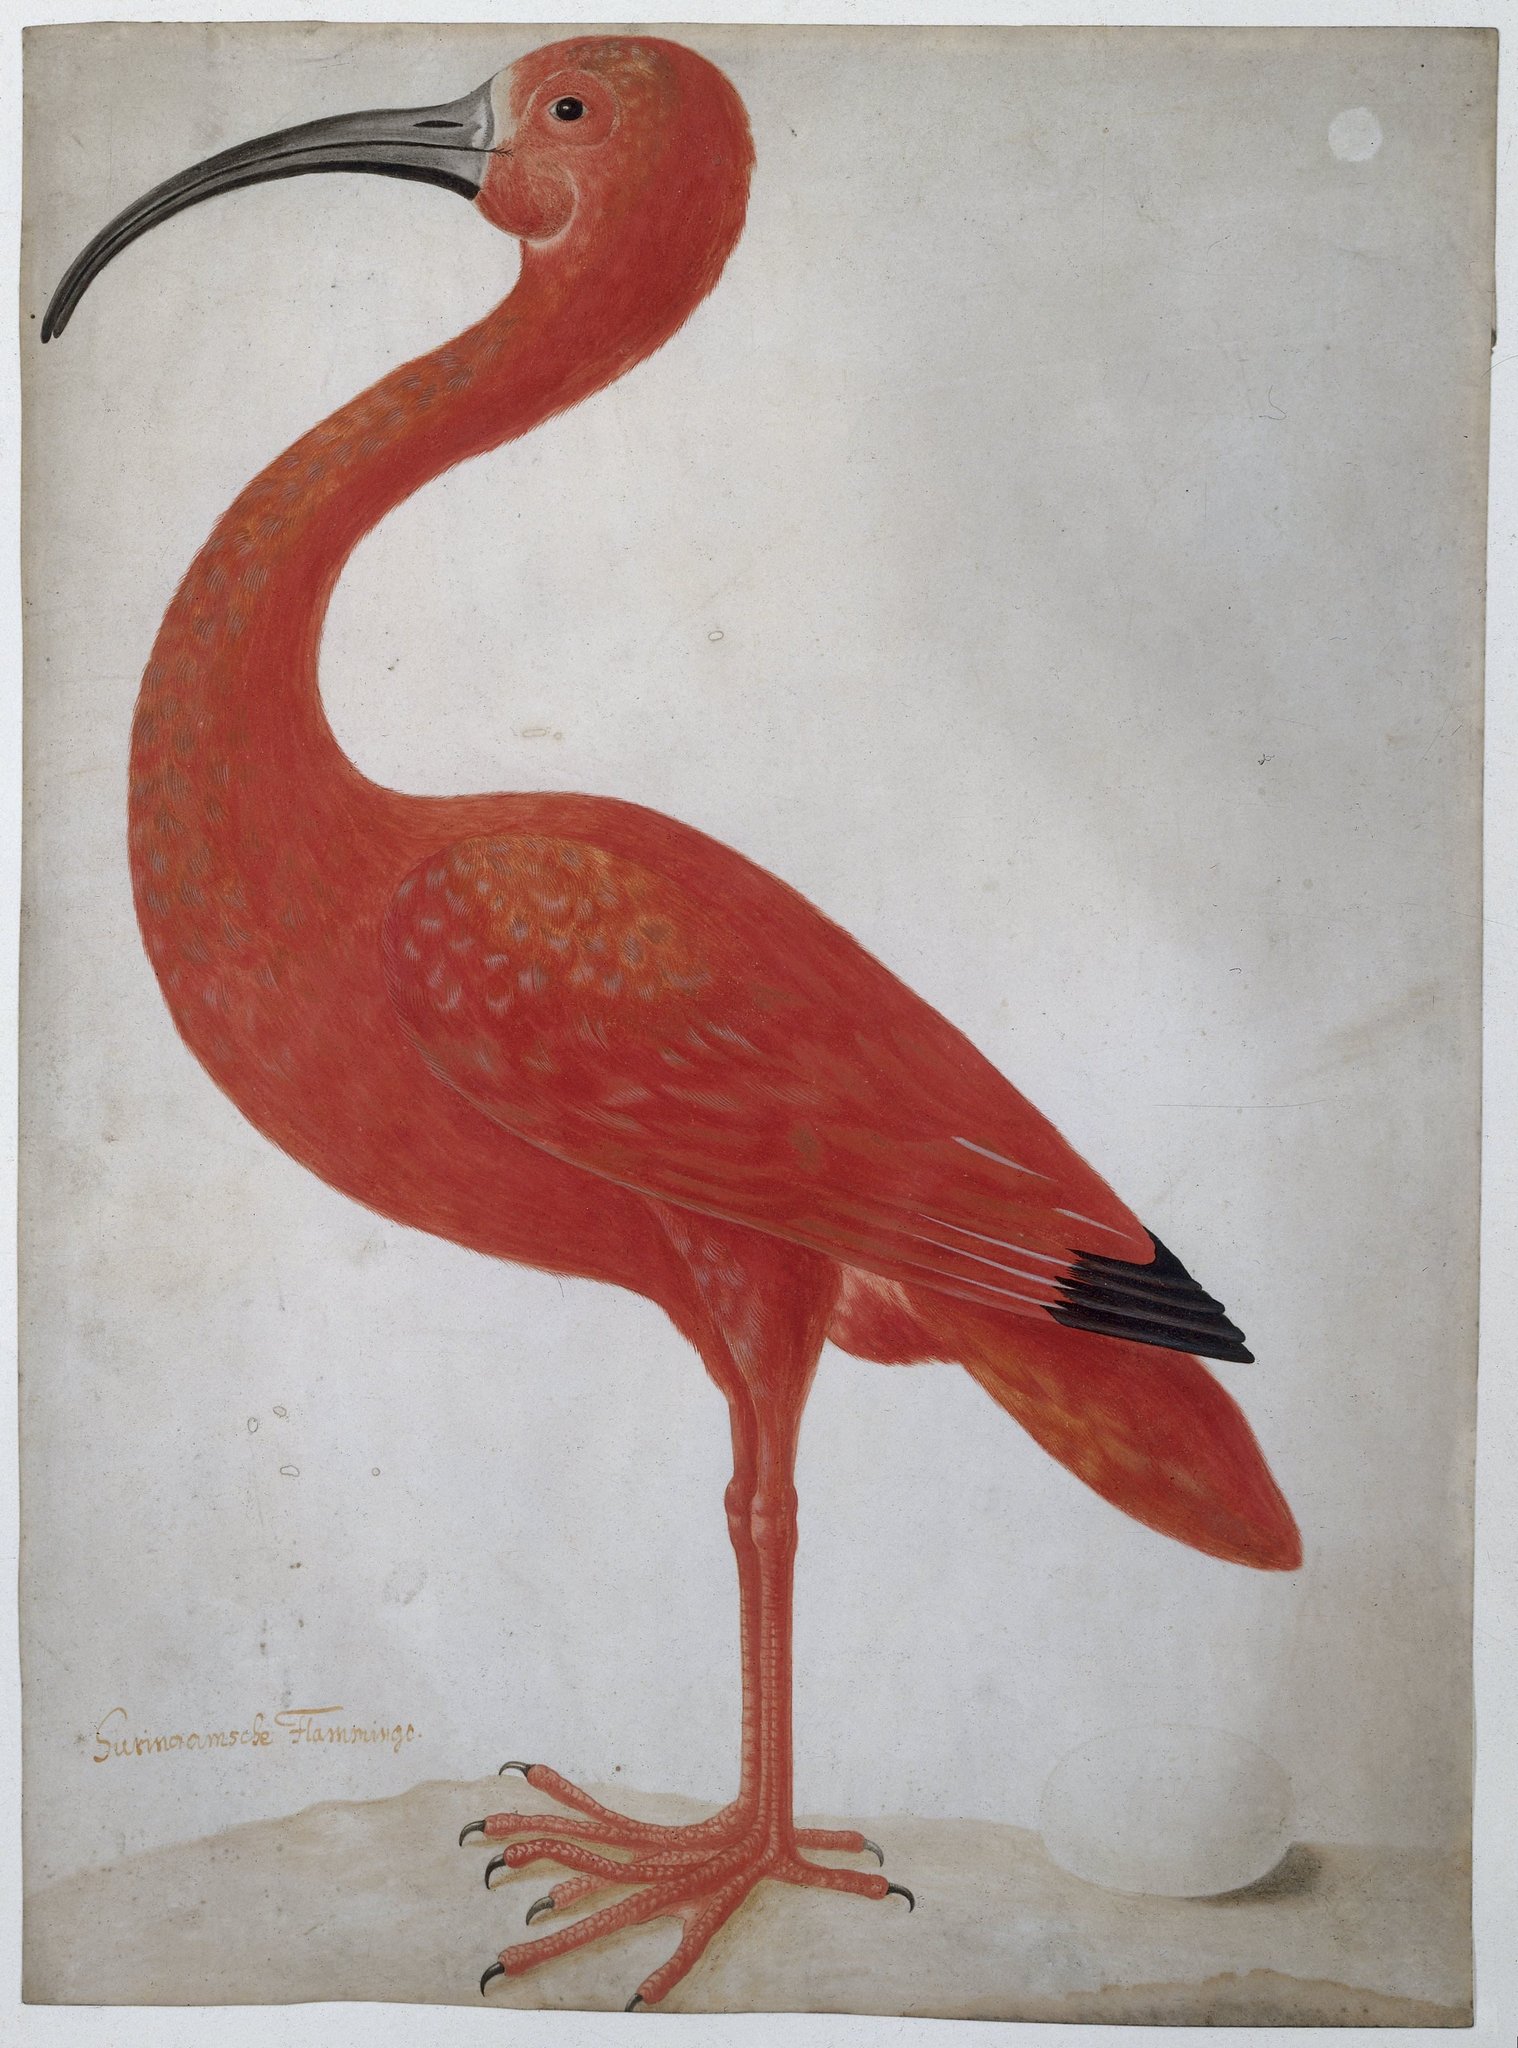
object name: drawing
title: Scarlet Ibis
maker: dorothea maria gsell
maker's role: draughtsman, painter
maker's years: 1678-1743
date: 1699-1701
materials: paint, gouache, parchment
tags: shore-birds and wading-birds: red ibis, shore-birds and wading-birds: red ibis (egg)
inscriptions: : ‘Surinaamsche Flammingo’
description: Dorothea Graff depicted this bird in Suriname, where she spent two years with her mother Maria Sibylla Merian observing and drawing native flora and fauna. An unidentified inscription incorrectly names the bird a flamingo. Graff portrayed the ibis in profile, as was customary in scientific illustrations at the time. She achieved the rich texture of the feathers by using a subtle tonal range and various brushstrokes.